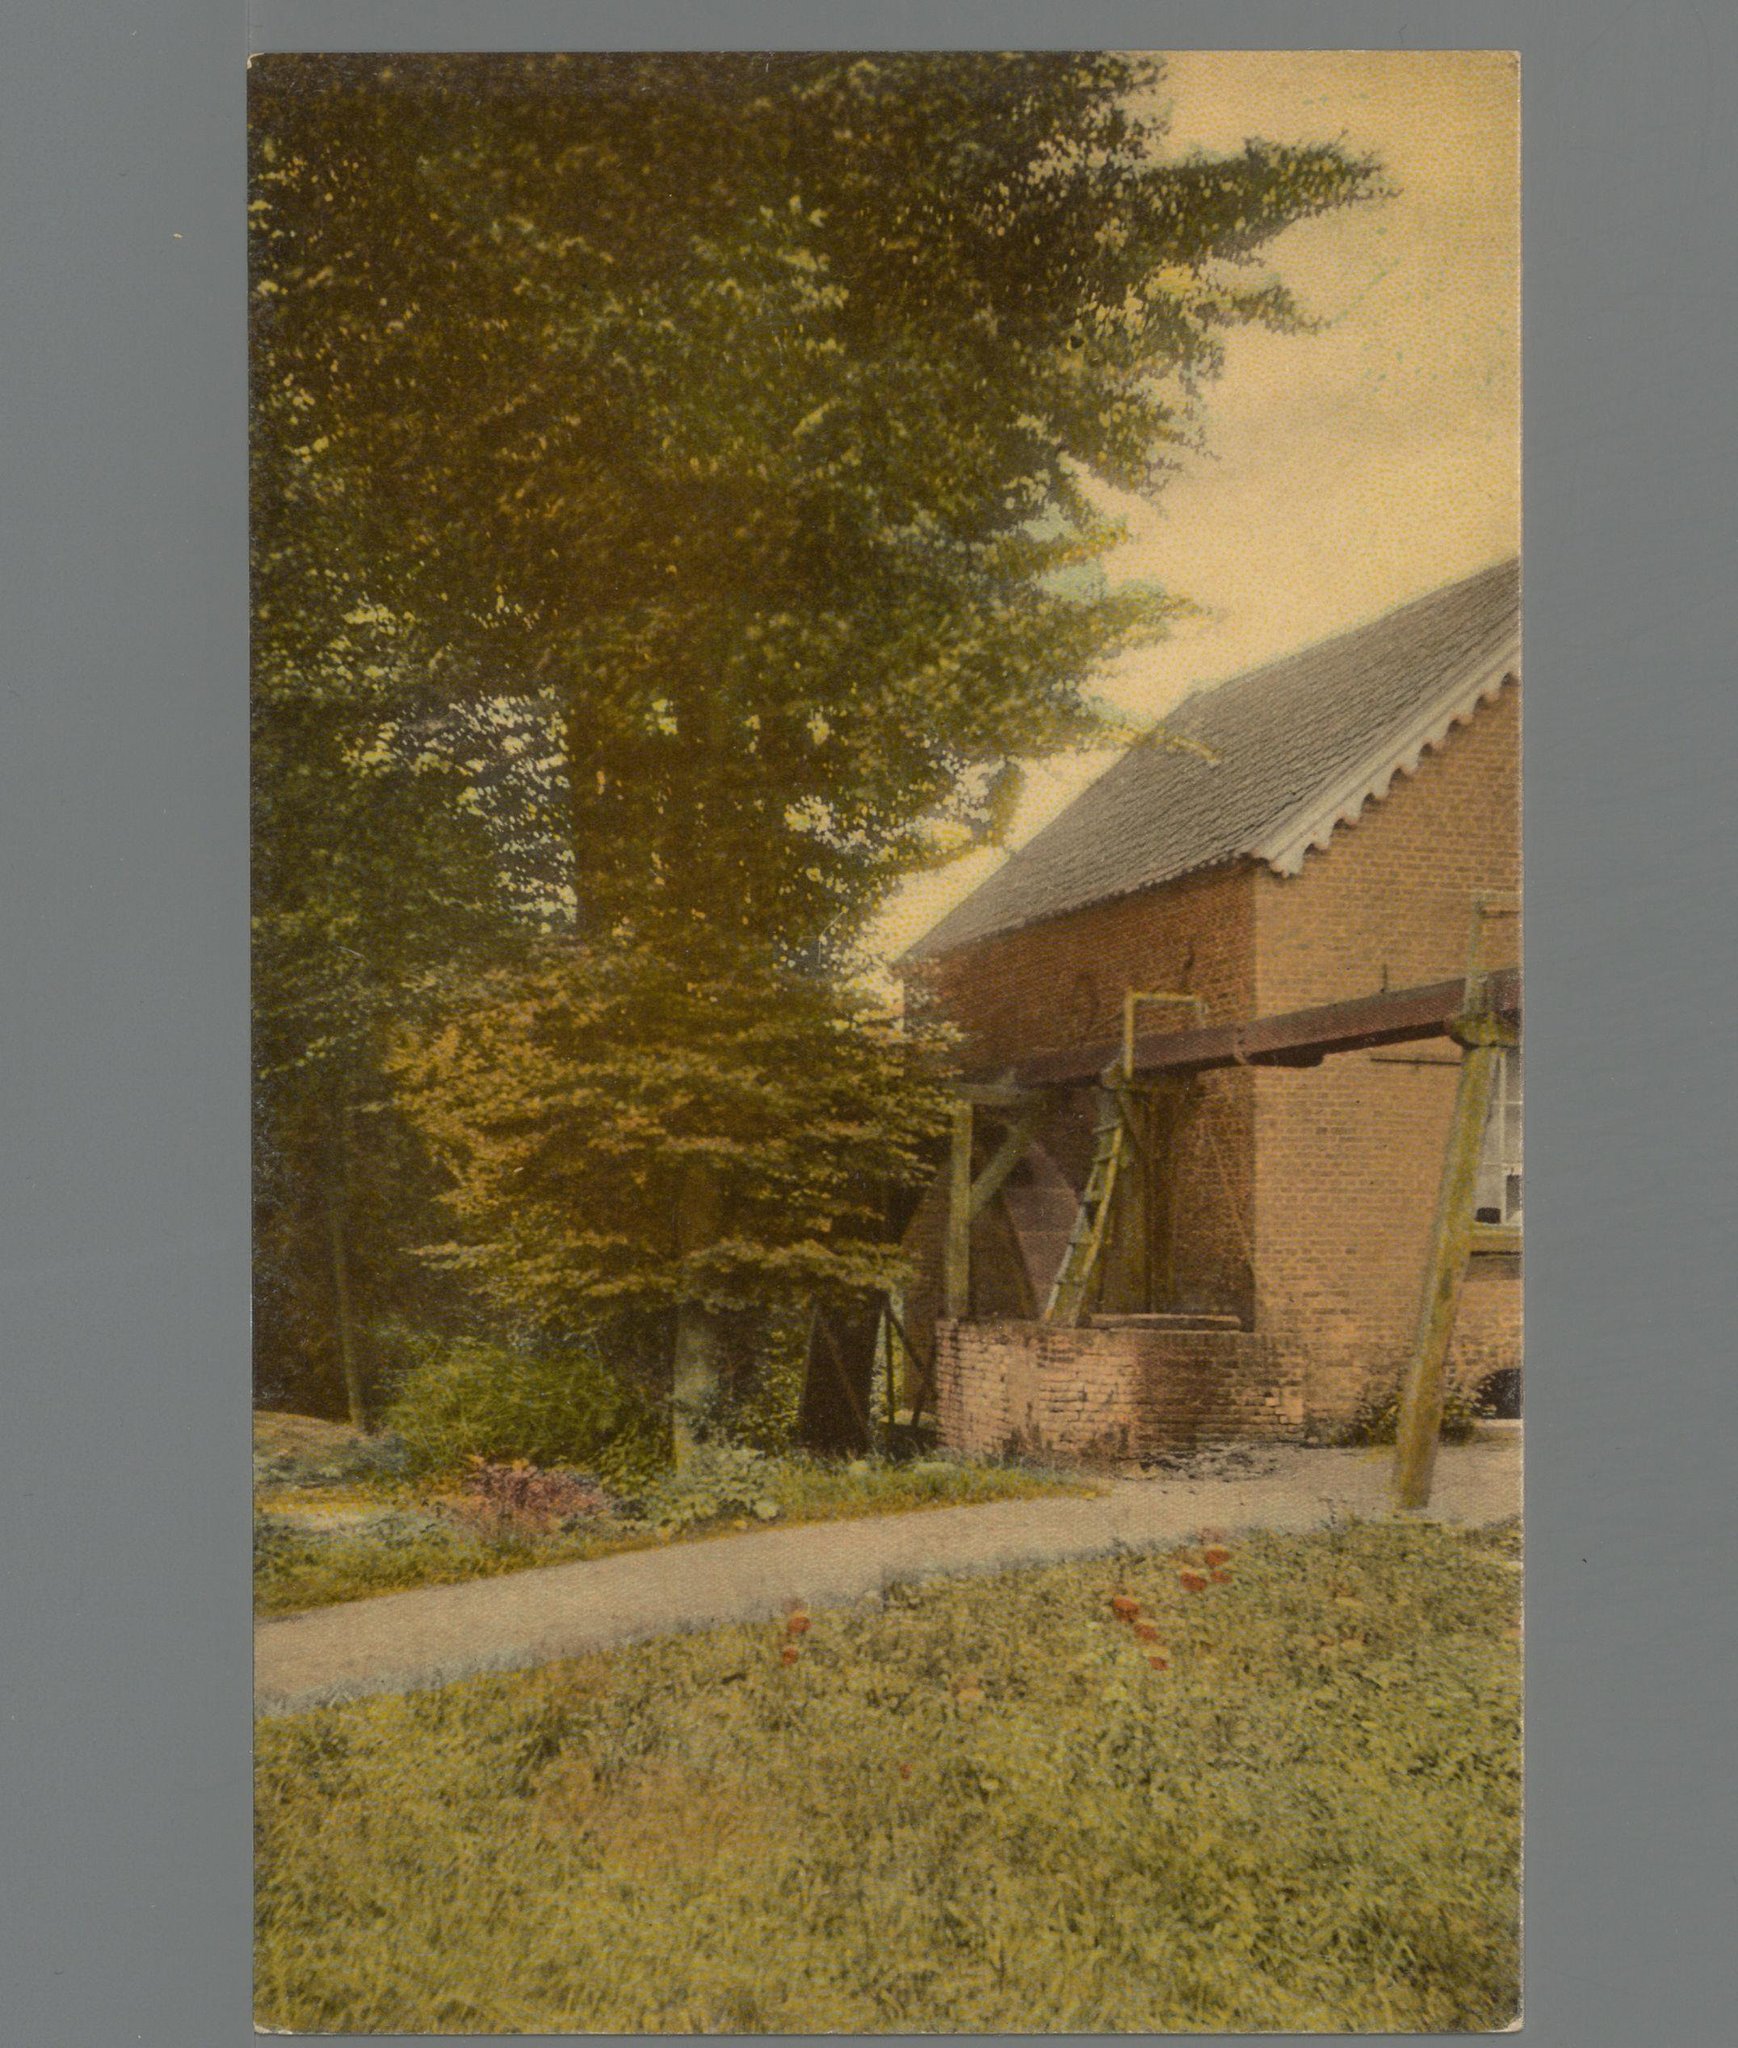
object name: ansichtkaart, prentbriefkaart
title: "Watermolen.". Hotel "de Plasmolen.". Mook bij Nijmegen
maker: Anonymous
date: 1905-1927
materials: cardboard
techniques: photograph, lithograph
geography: mook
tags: rural housing, e.g. country-house, villa, cottage, forest, wood